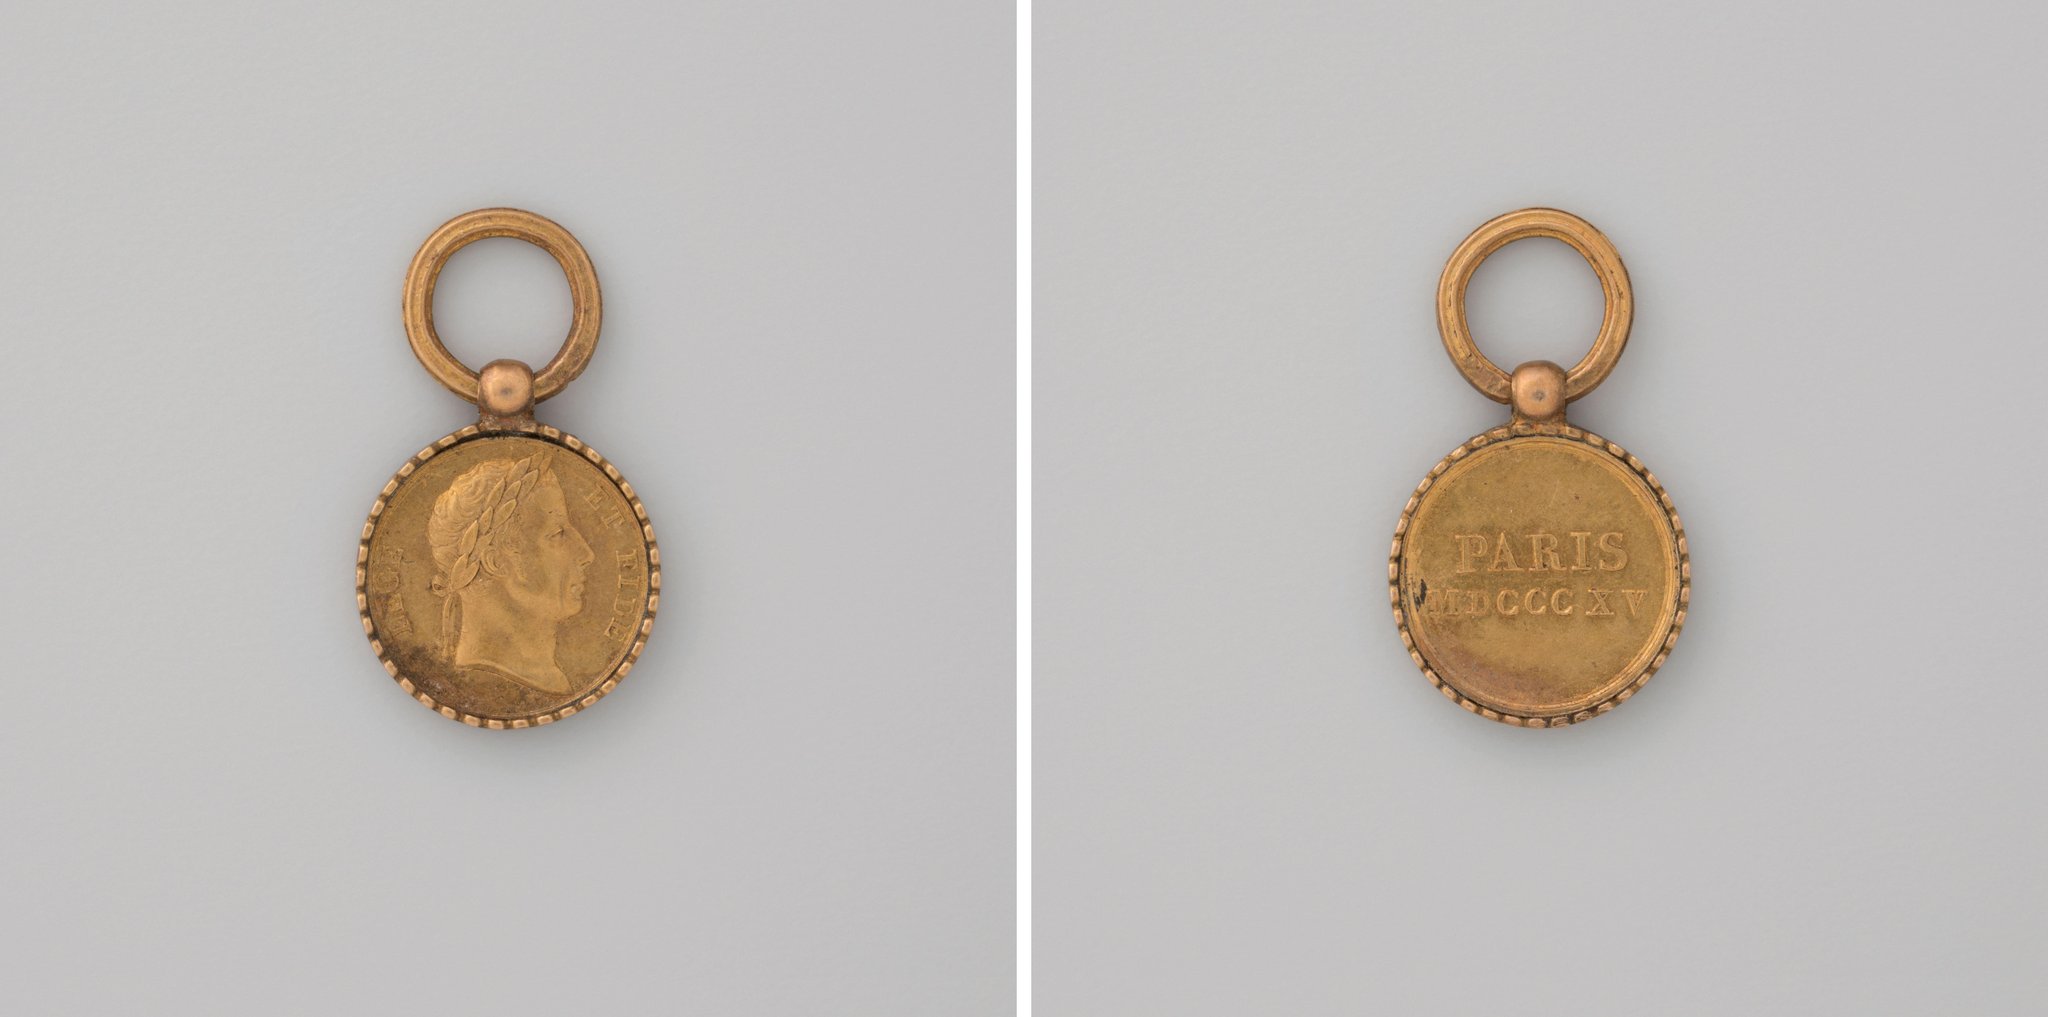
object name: history medal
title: Frans I, keizer van Oostenrijk, ter ere van de inname van Parijs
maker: Anonymous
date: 1815-1820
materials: gold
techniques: striking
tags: vienna, frans ii (rooms-duits keizer), paris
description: Gouden penning aan draagoog en draagring. Voorzijde: borststuk man met lauwerkrans binnen omschrift en sierrand. Keerzijde: opschrift binnen sierrand.